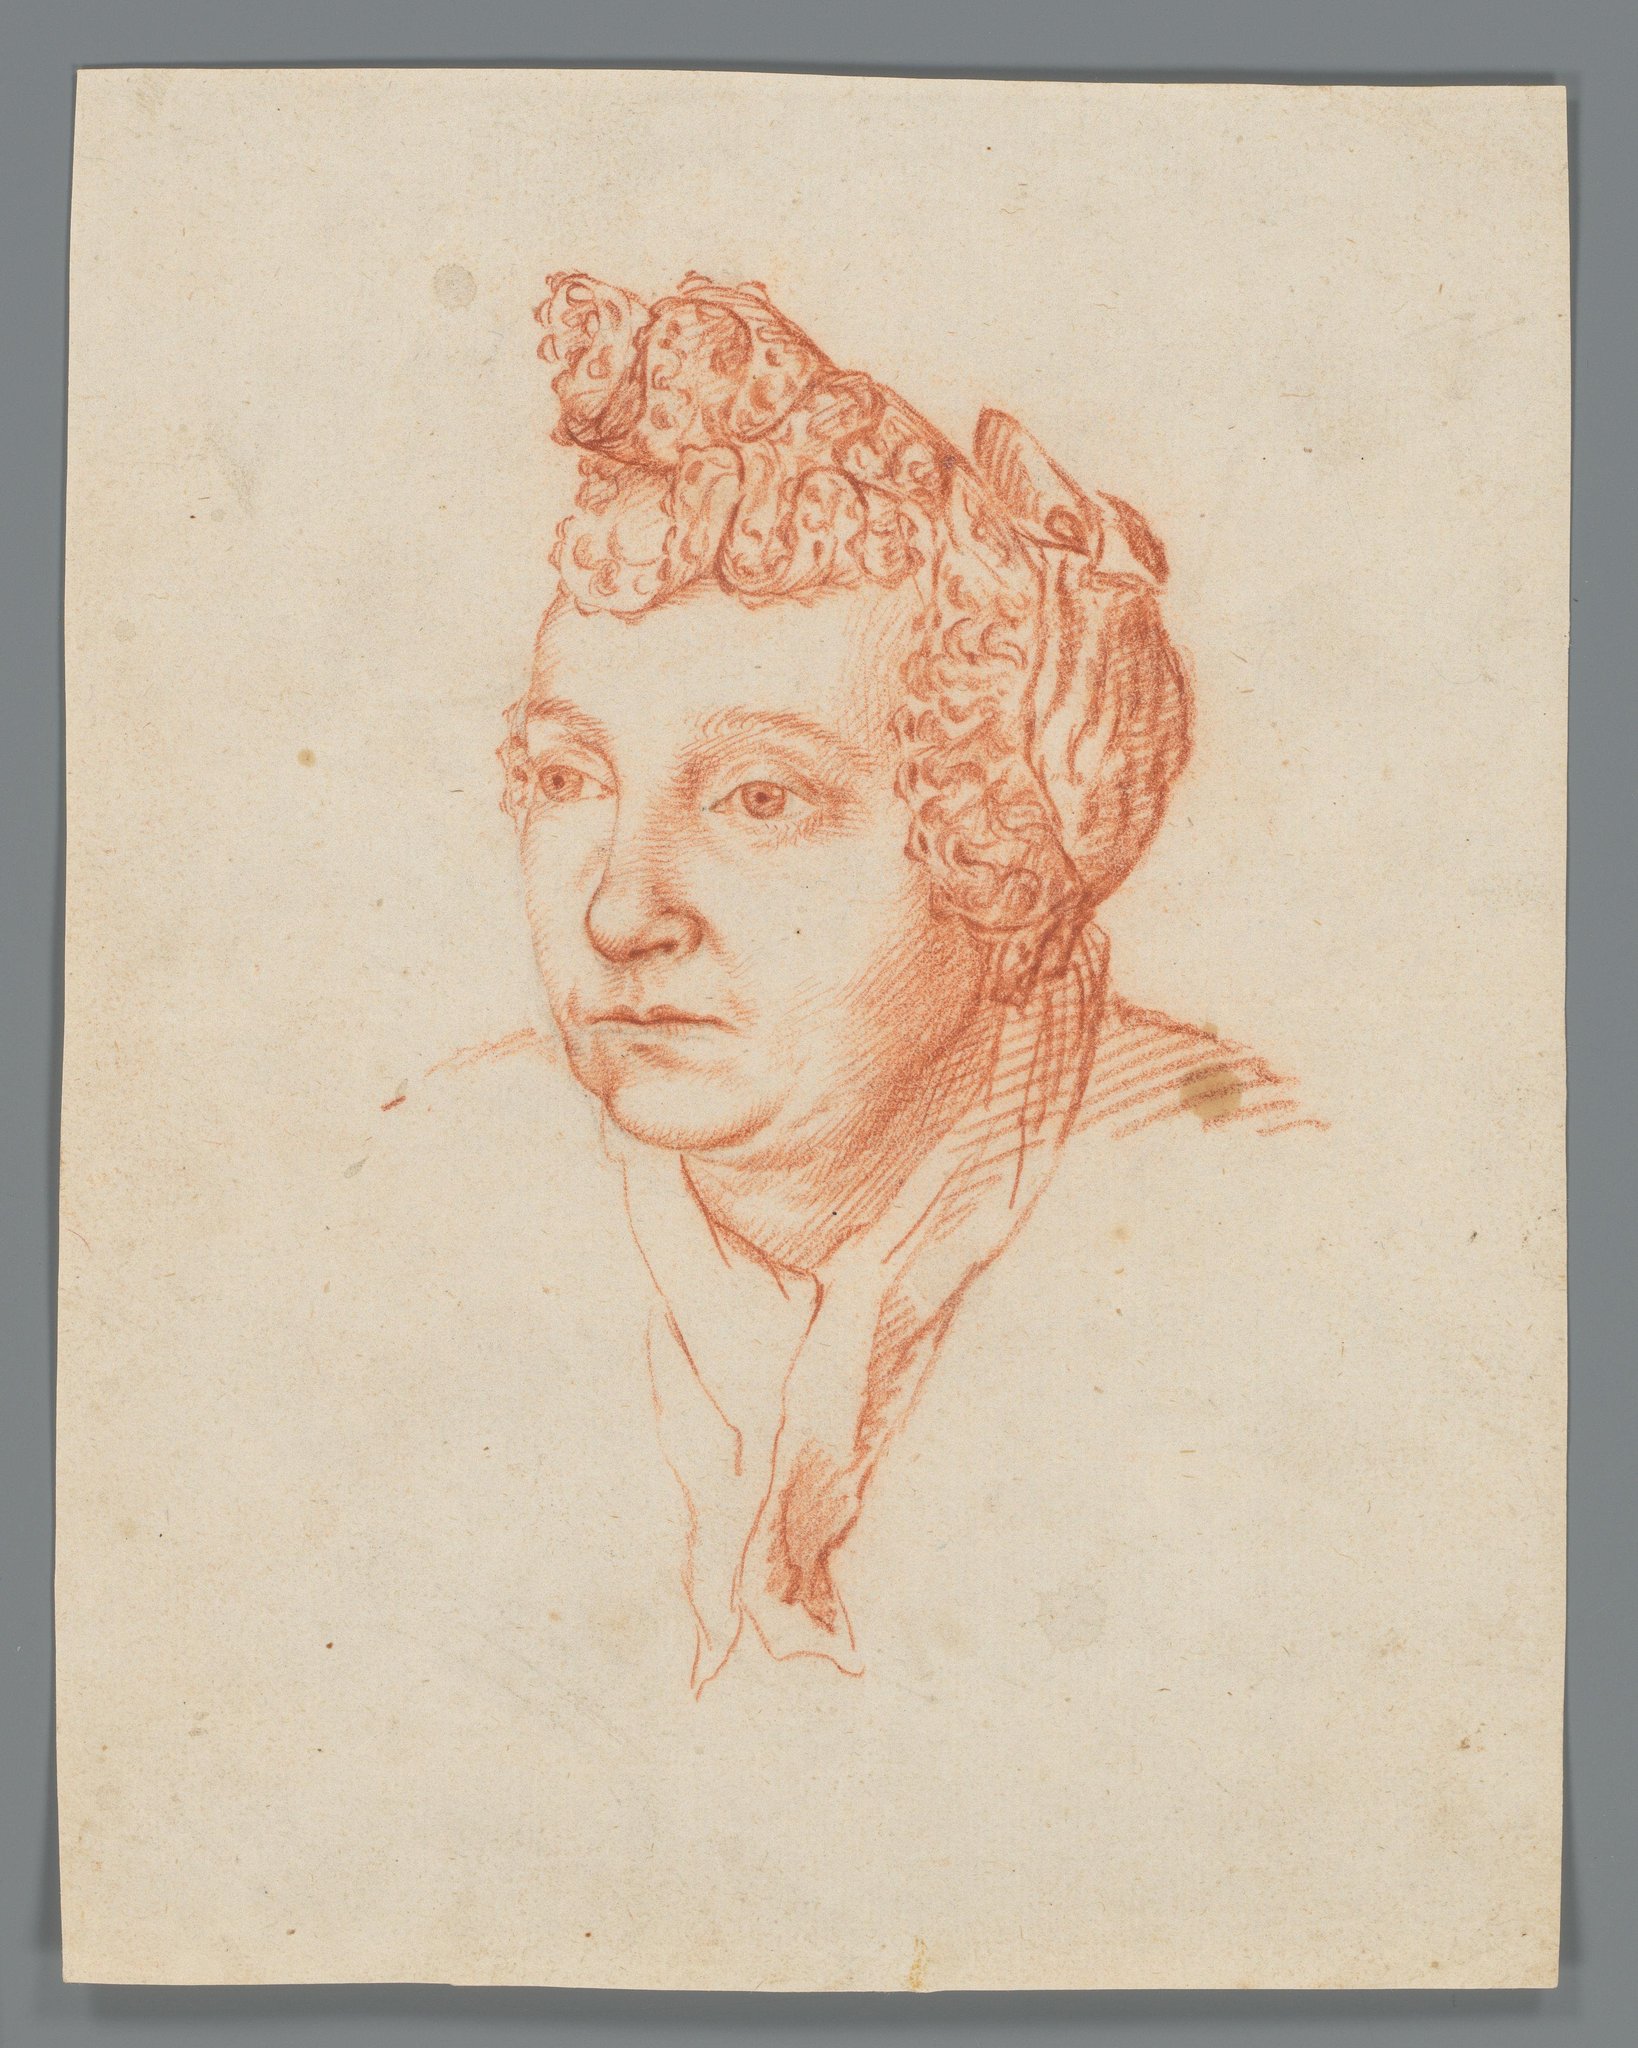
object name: drawing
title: Portret van een vrouw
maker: matthijs balen (1684-1766)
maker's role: draughtsman, painter, print maker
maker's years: 1684-1766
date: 1694-1766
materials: chalk, paper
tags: historical persons not known by name - bb - woman